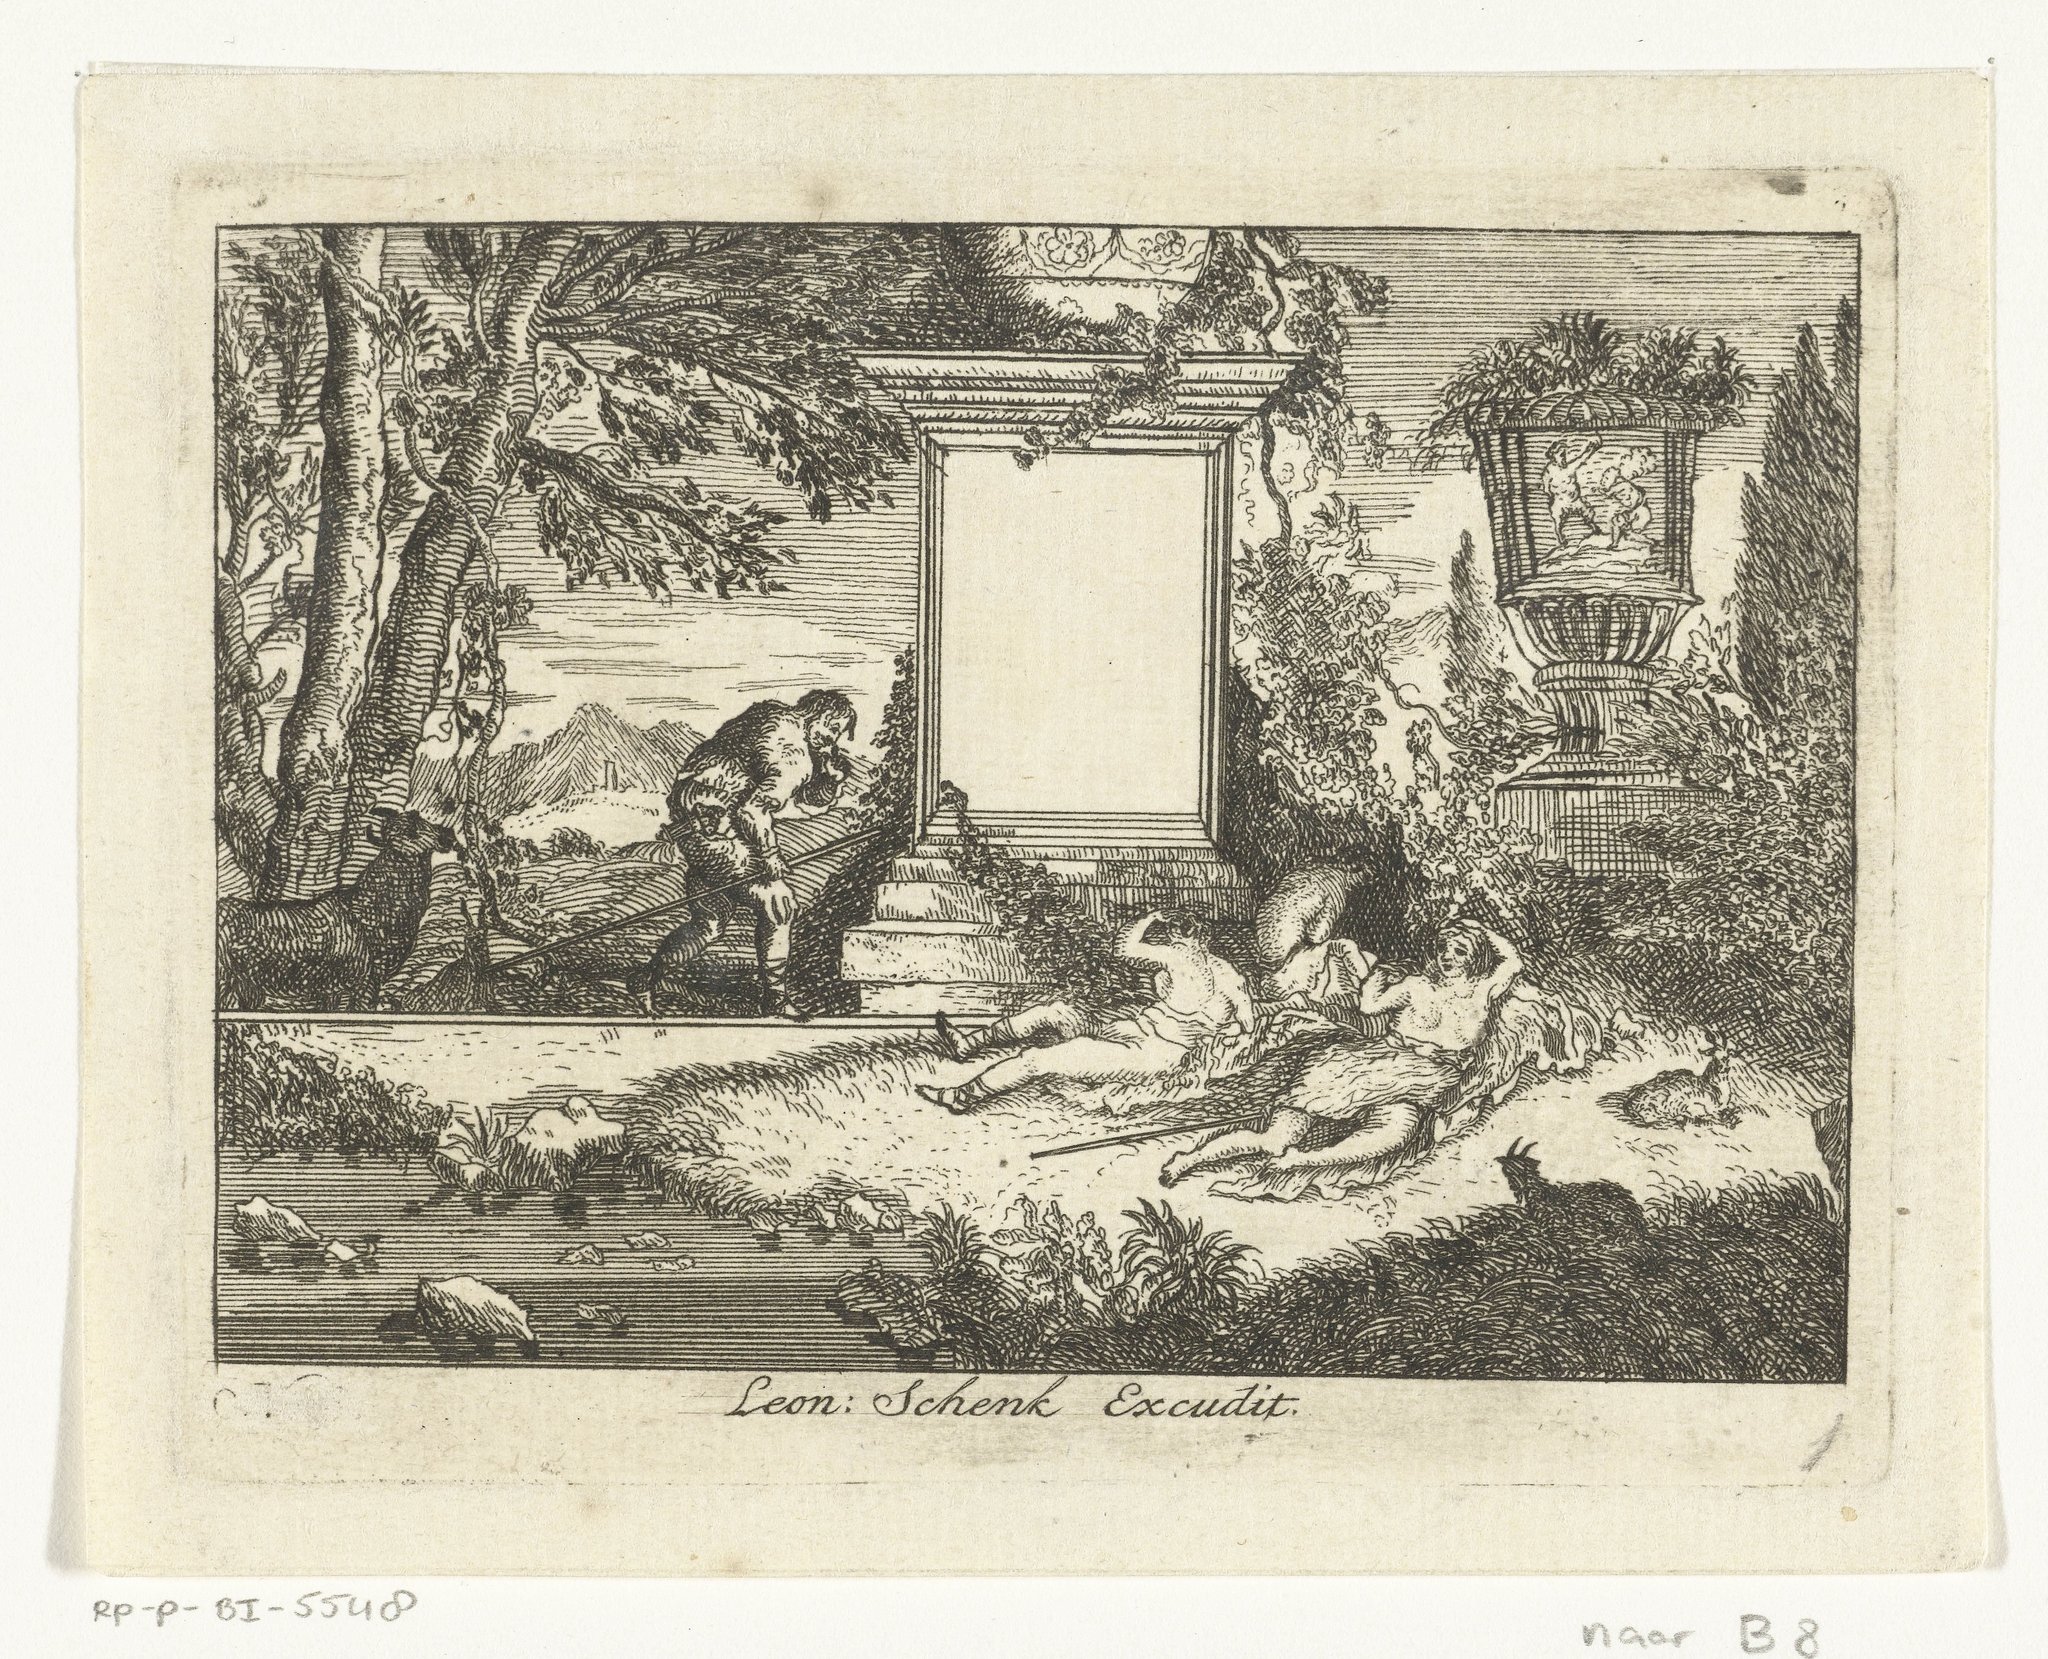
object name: print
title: Herder besluipt rustende herderinnen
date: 1710-1746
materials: paper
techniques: etching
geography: france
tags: herding, herdsman, herdswoman, shepherd, shepherdess, cowherd, etc., sleeping; unconsciousness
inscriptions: collector's mark: Lugt 2228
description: Drie schaars geklede vrouwen aan de voet van een zuil waarnaast een staande man, een koe en enkele geiten.